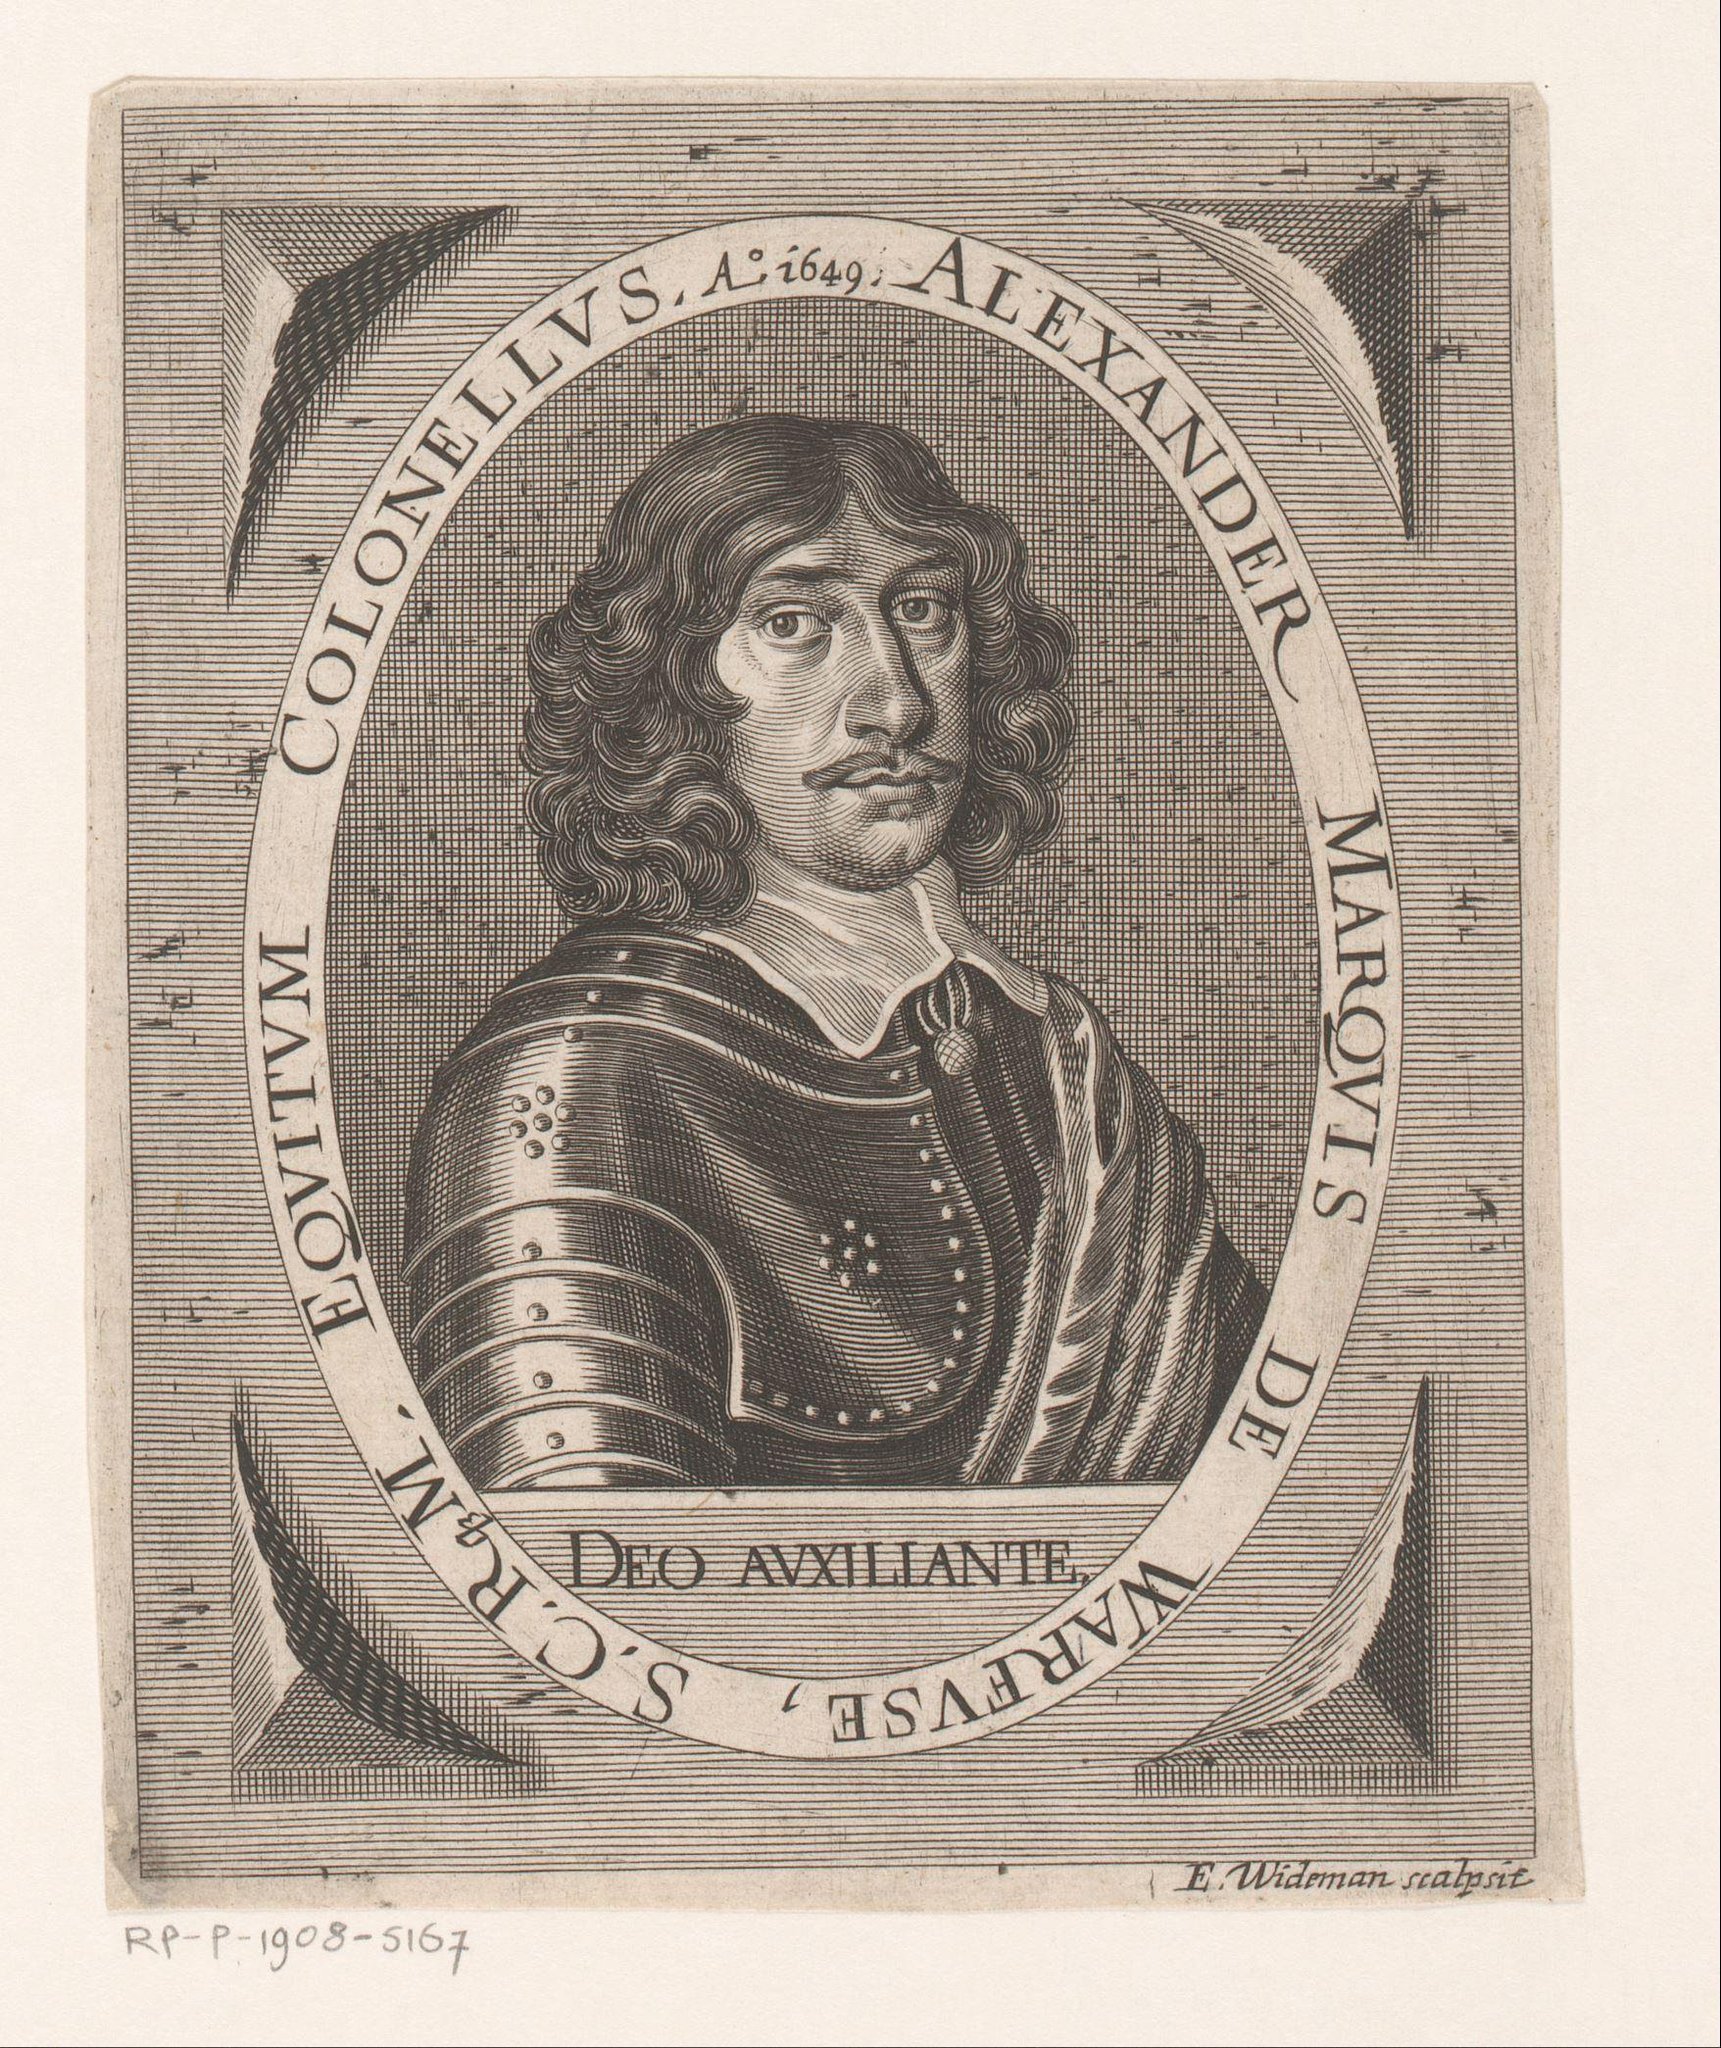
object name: print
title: Portret van Alexandre de Warfusée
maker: elias widemann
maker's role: print maker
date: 1649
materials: paper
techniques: engraving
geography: vienna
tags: historical persons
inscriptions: collector's mark: Lugt 2228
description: Prent uit de publicatie: Widemann, Elias. Honori Sacrum. Wenen: s.n., 1649.